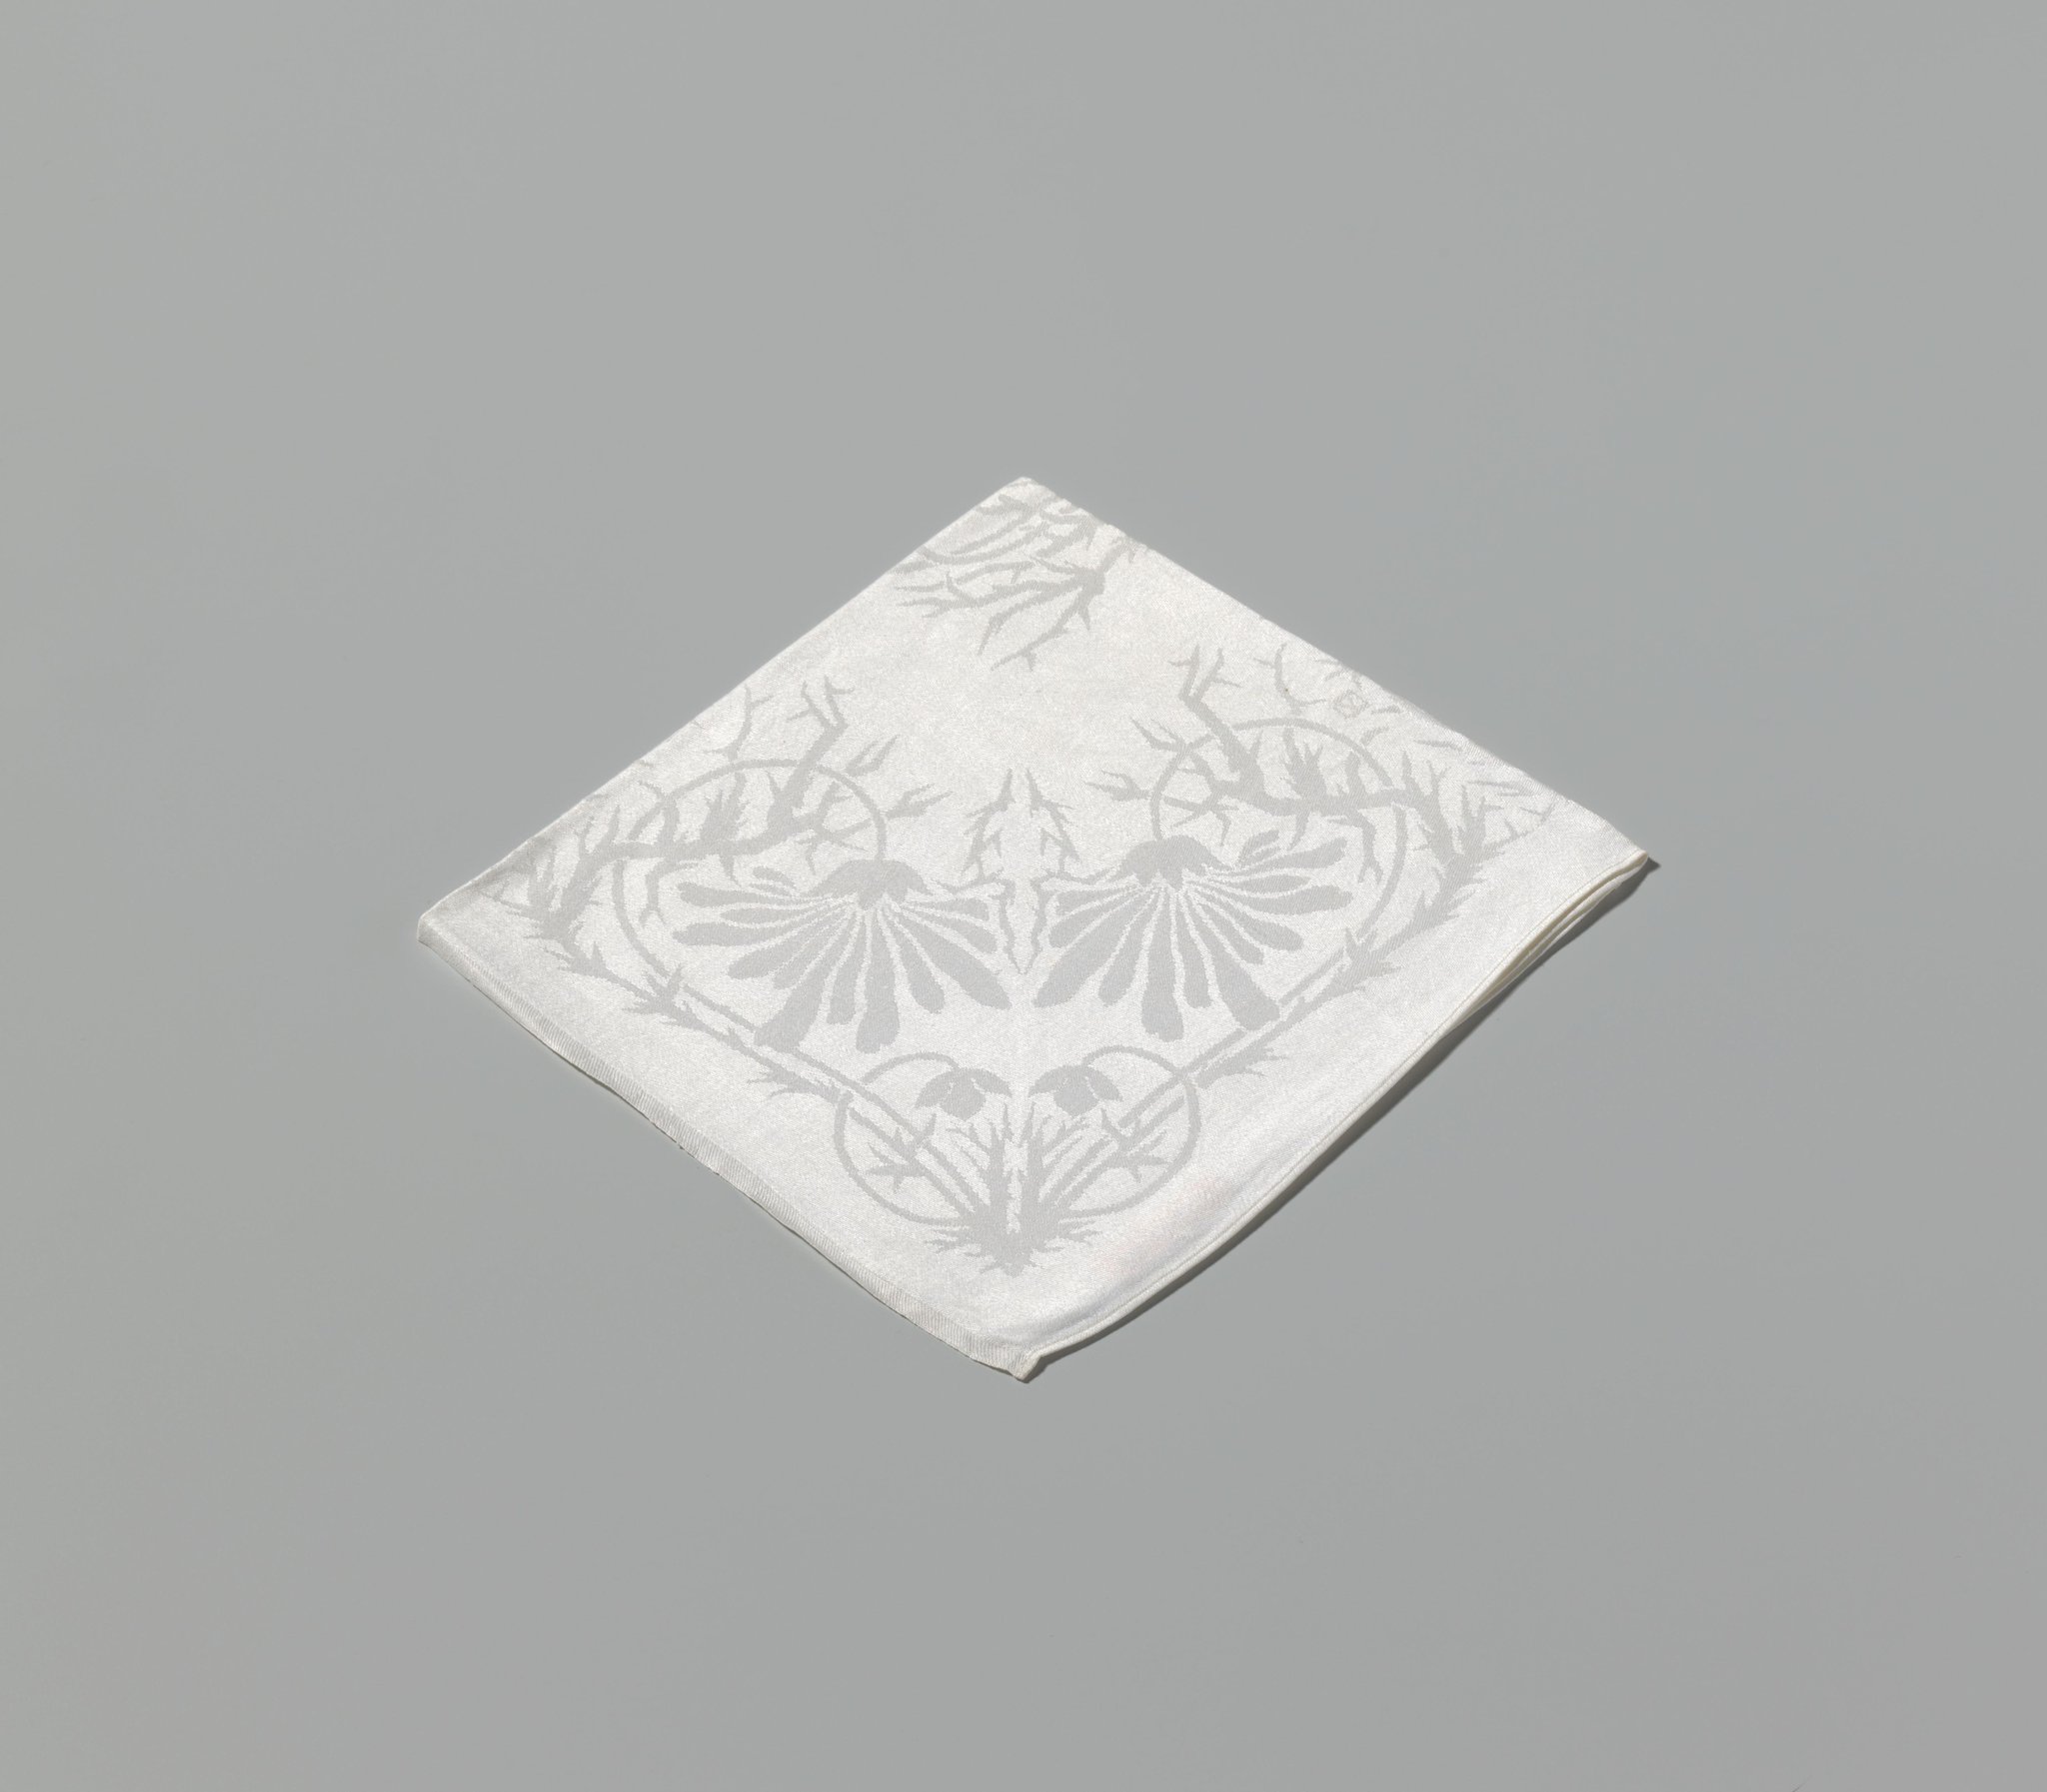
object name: vingerdoek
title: Vingerdoek van linnendamast met dessin Marguerite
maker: cornelis van der sluys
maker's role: print maker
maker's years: 1881-1944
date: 1904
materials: linen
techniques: damask, weave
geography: eindhoven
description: Vingerdoek van linnendamast met een bloempatroon: motief Marguerite, dessin nr. 500. De vingerdoek hoort bij elf vingerdoeken, dertien servetten en een tafellaken.